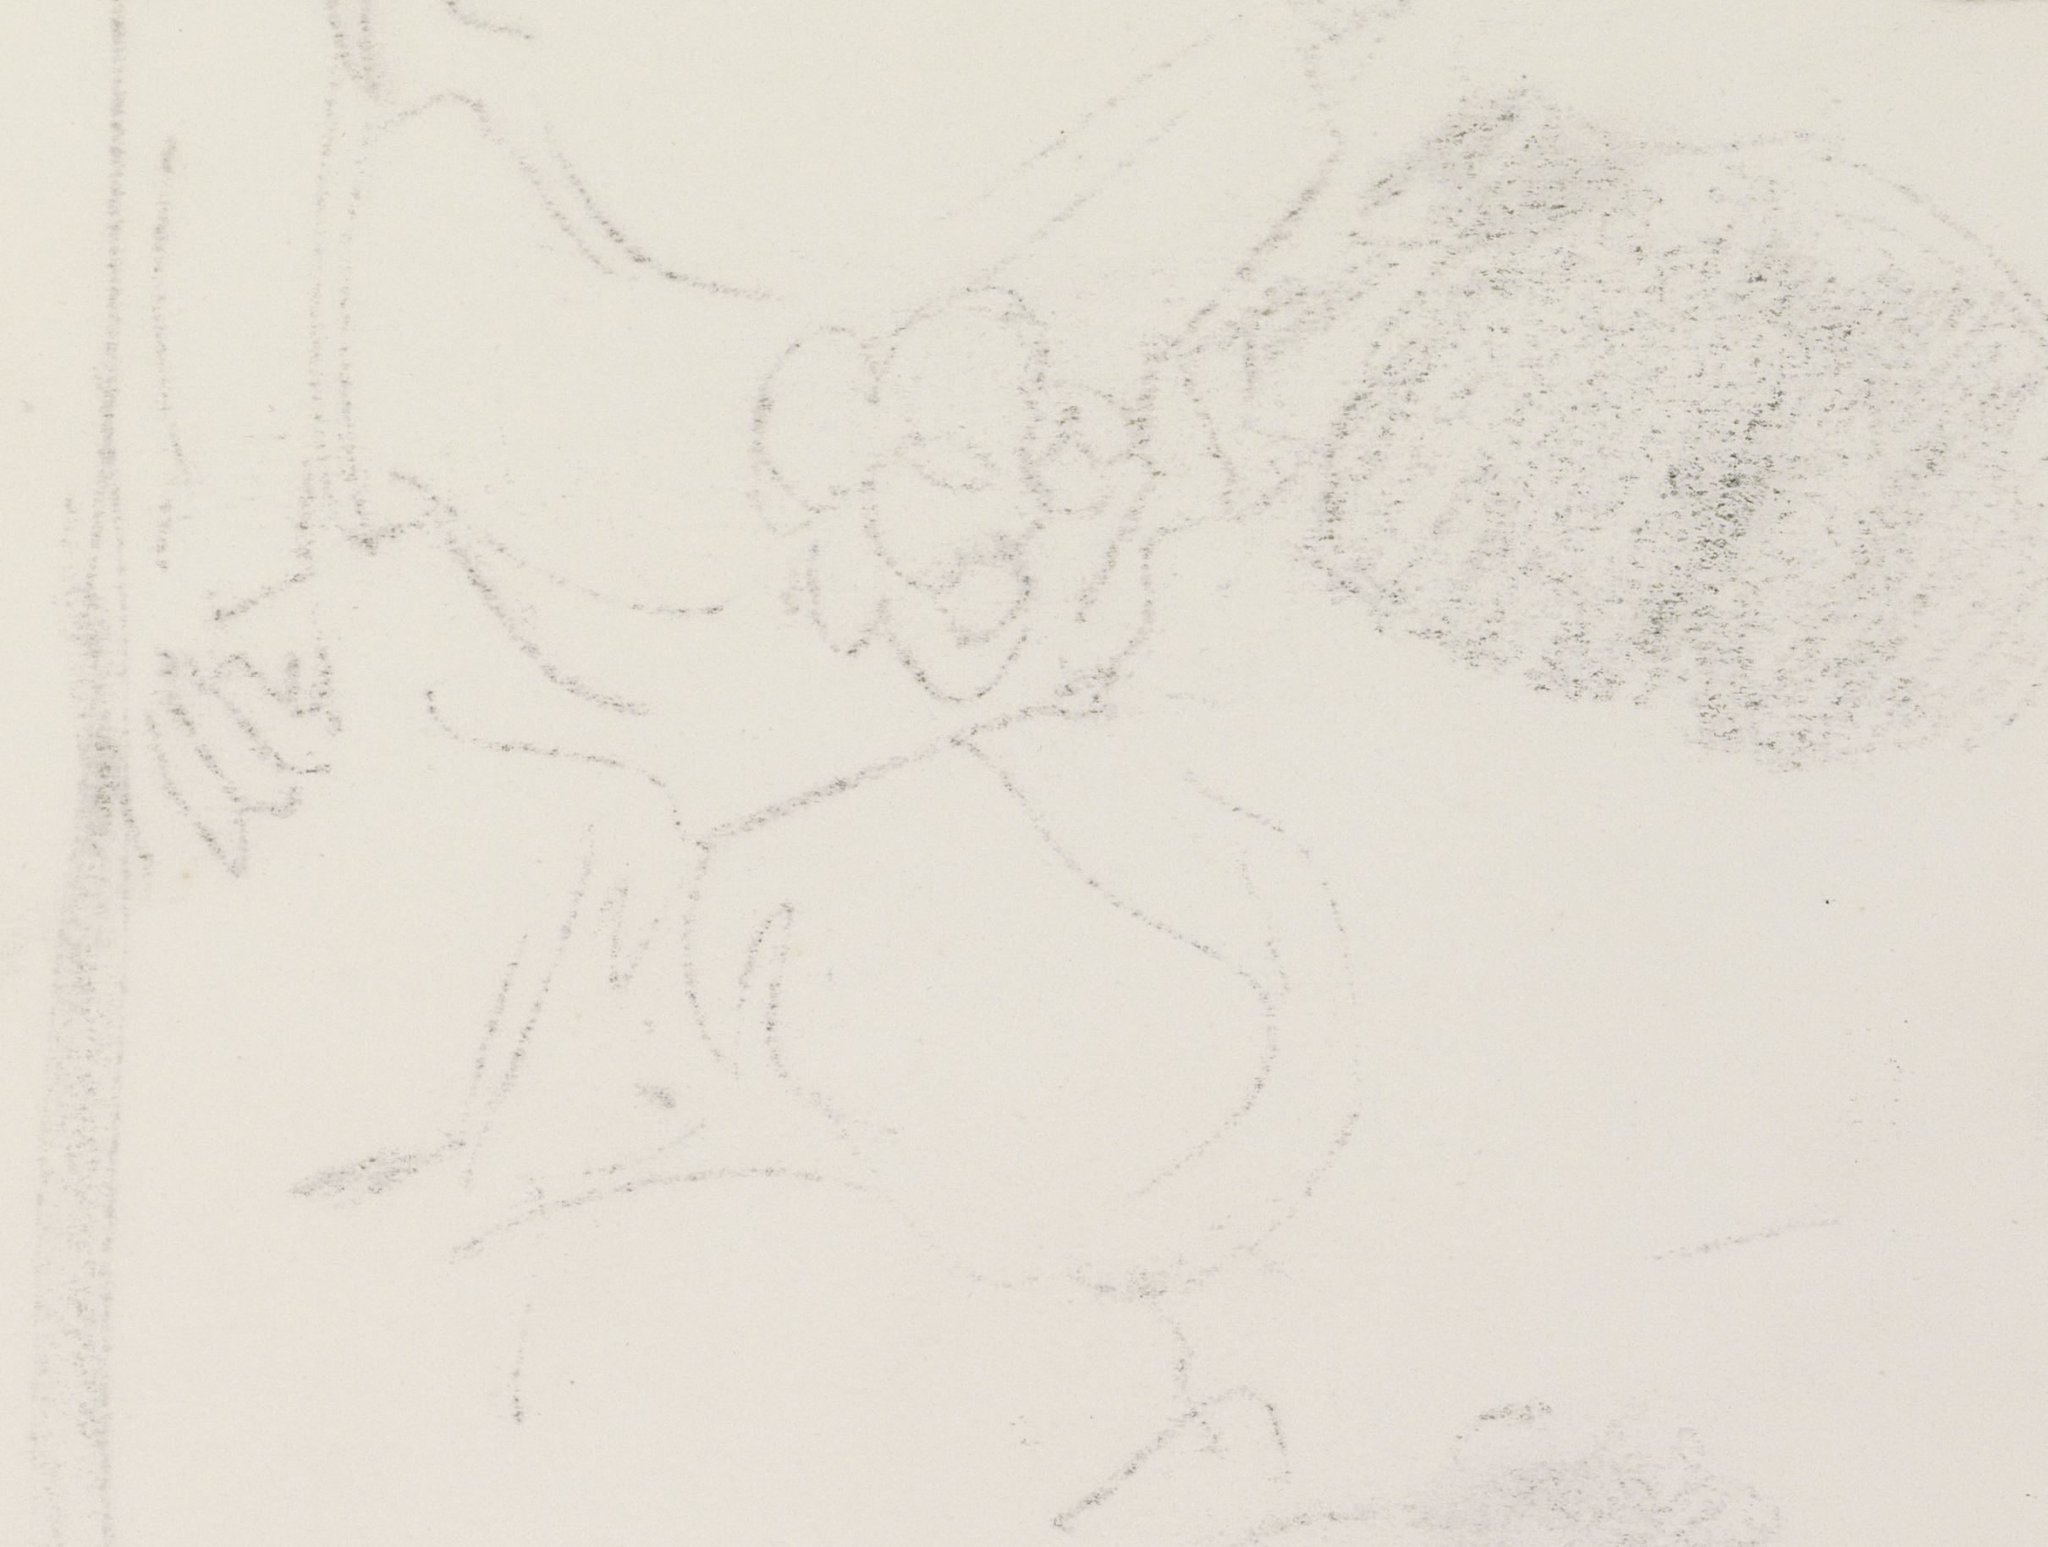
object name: sketchbook leaf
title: Abklatsch van de krijttekening op blad 14 recto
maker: isaac israels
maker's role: draughtsman, painter, print maker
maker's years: 1865-1934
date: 1875-1934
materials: paper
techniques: printmaking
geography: the hague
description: Blad 13 verso uit schetsboek VII met 26 bladen.